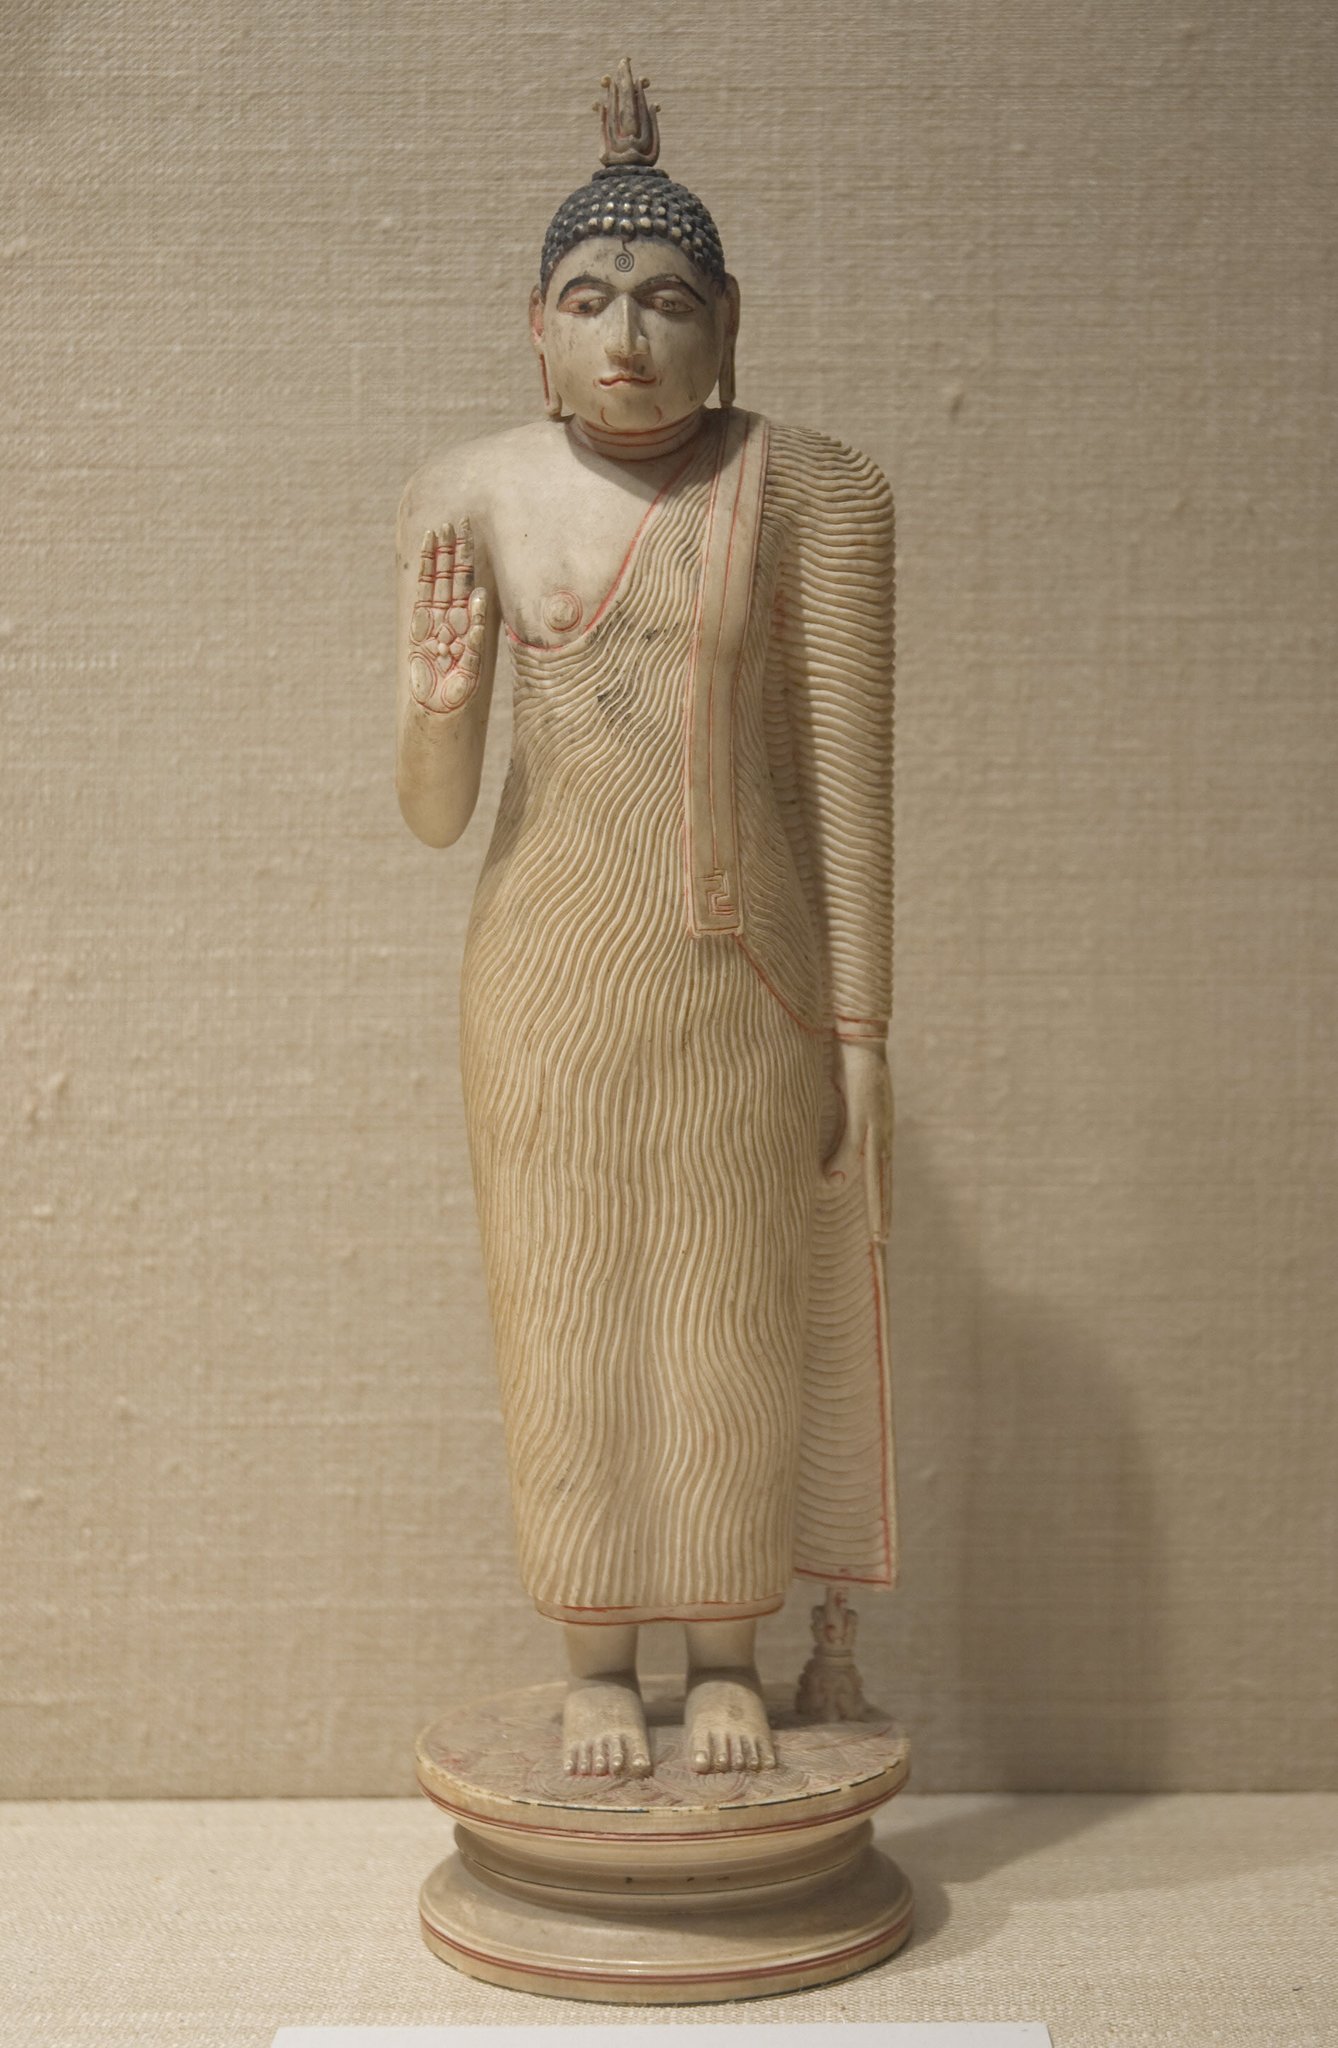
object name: figure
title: Buddha Offering Protection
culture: sri lanka, kandy district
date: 1701-1800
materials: ivory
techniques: polychrome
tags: buddhism,buddha